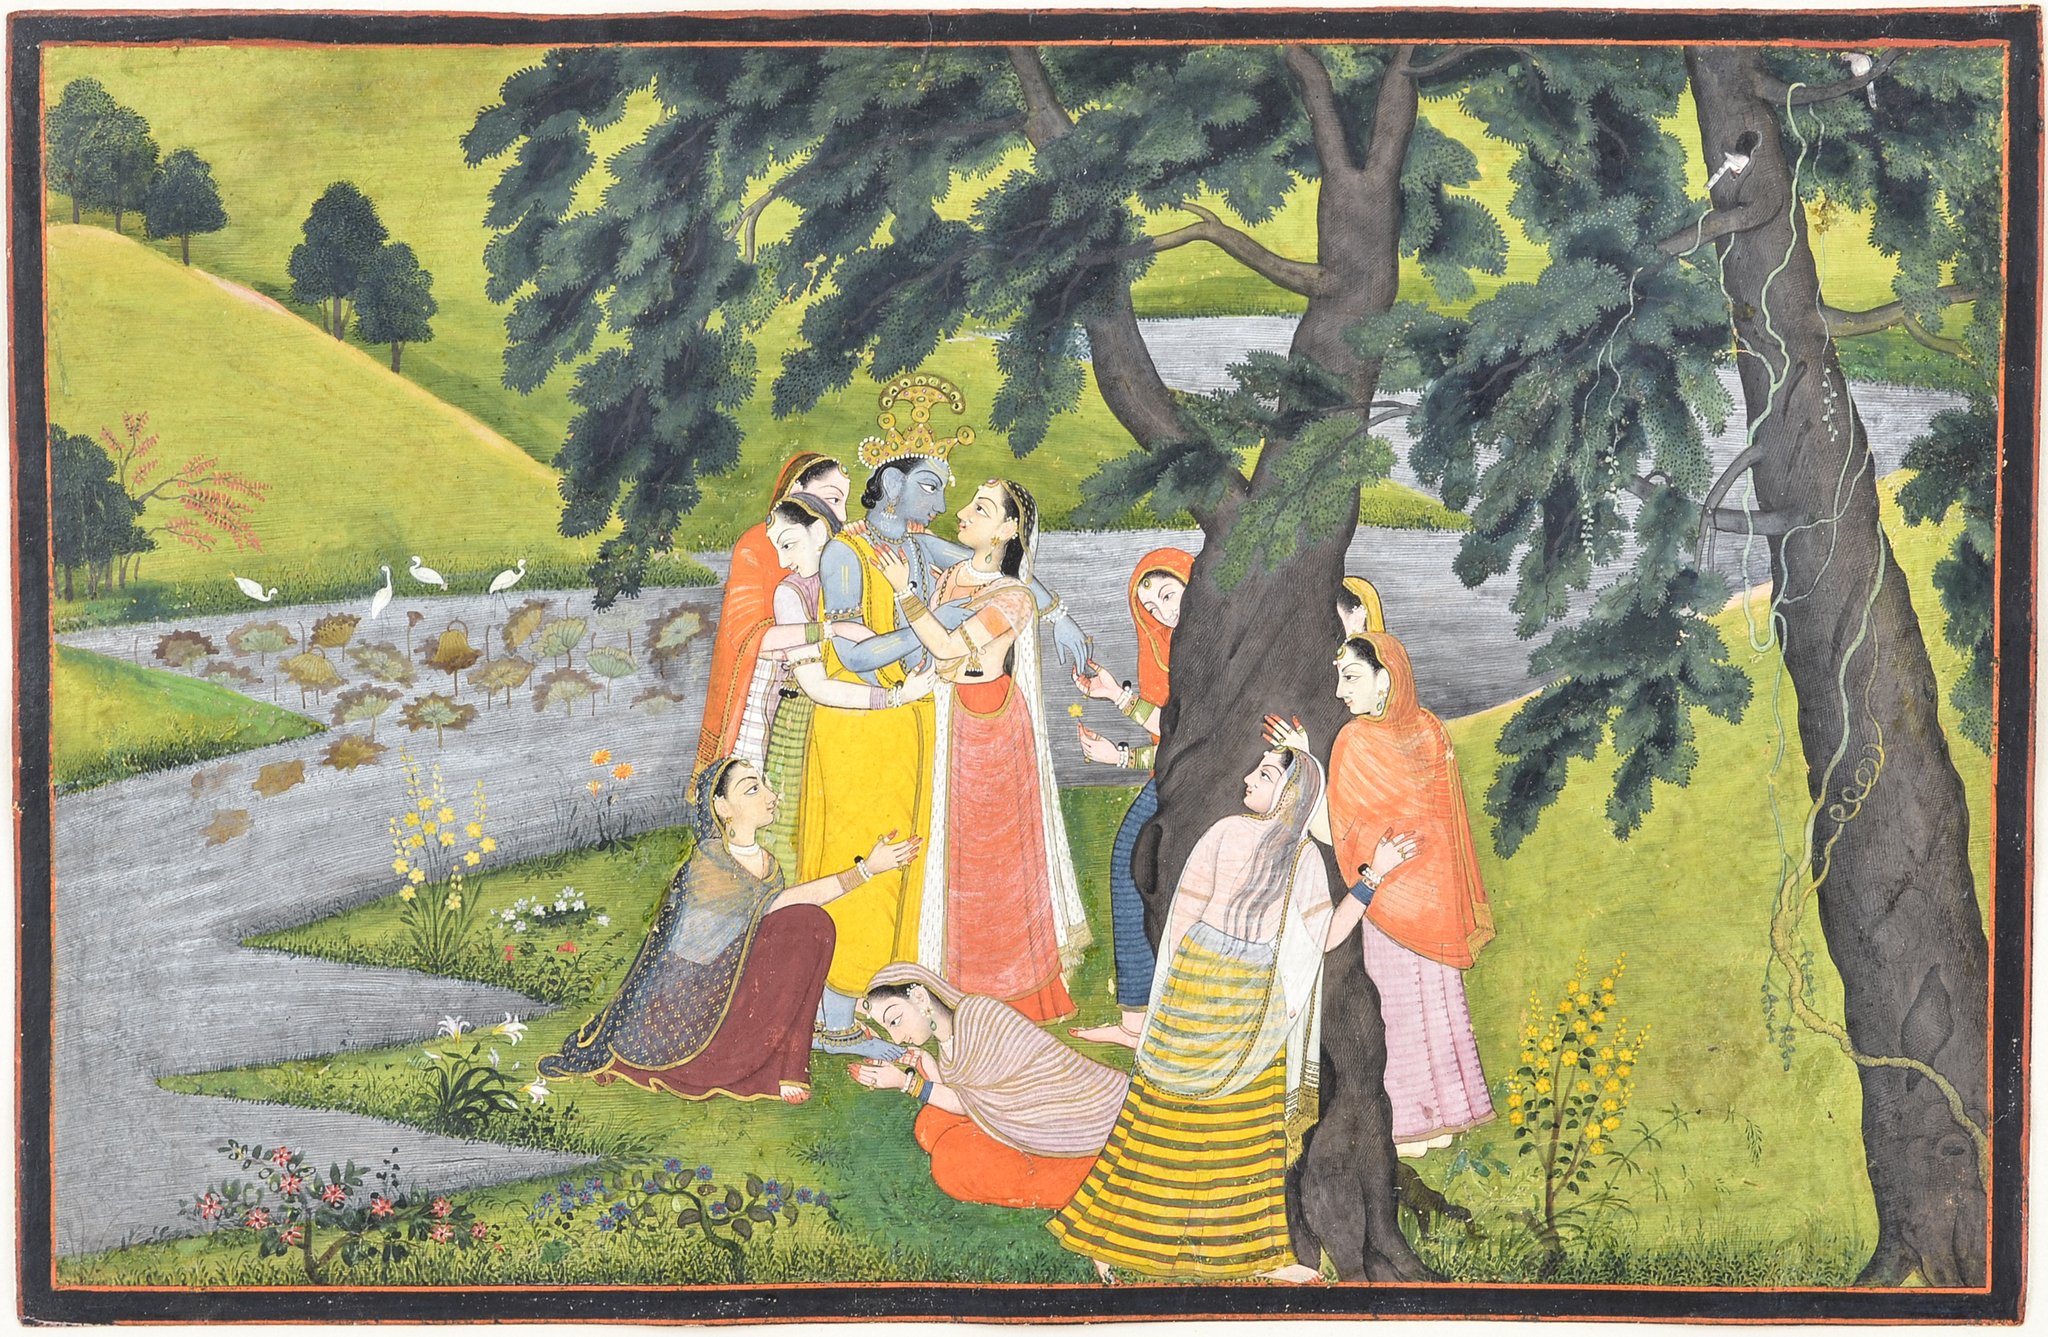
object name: folio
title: "Krishna and the Gopis on the Bank of the Yamuna River", Folio from the "Second" or "Tehri Garhwal" Gita Govinda (Song of the Cowherd)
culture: indian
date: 1775-1780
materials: gold, paper, watercolor